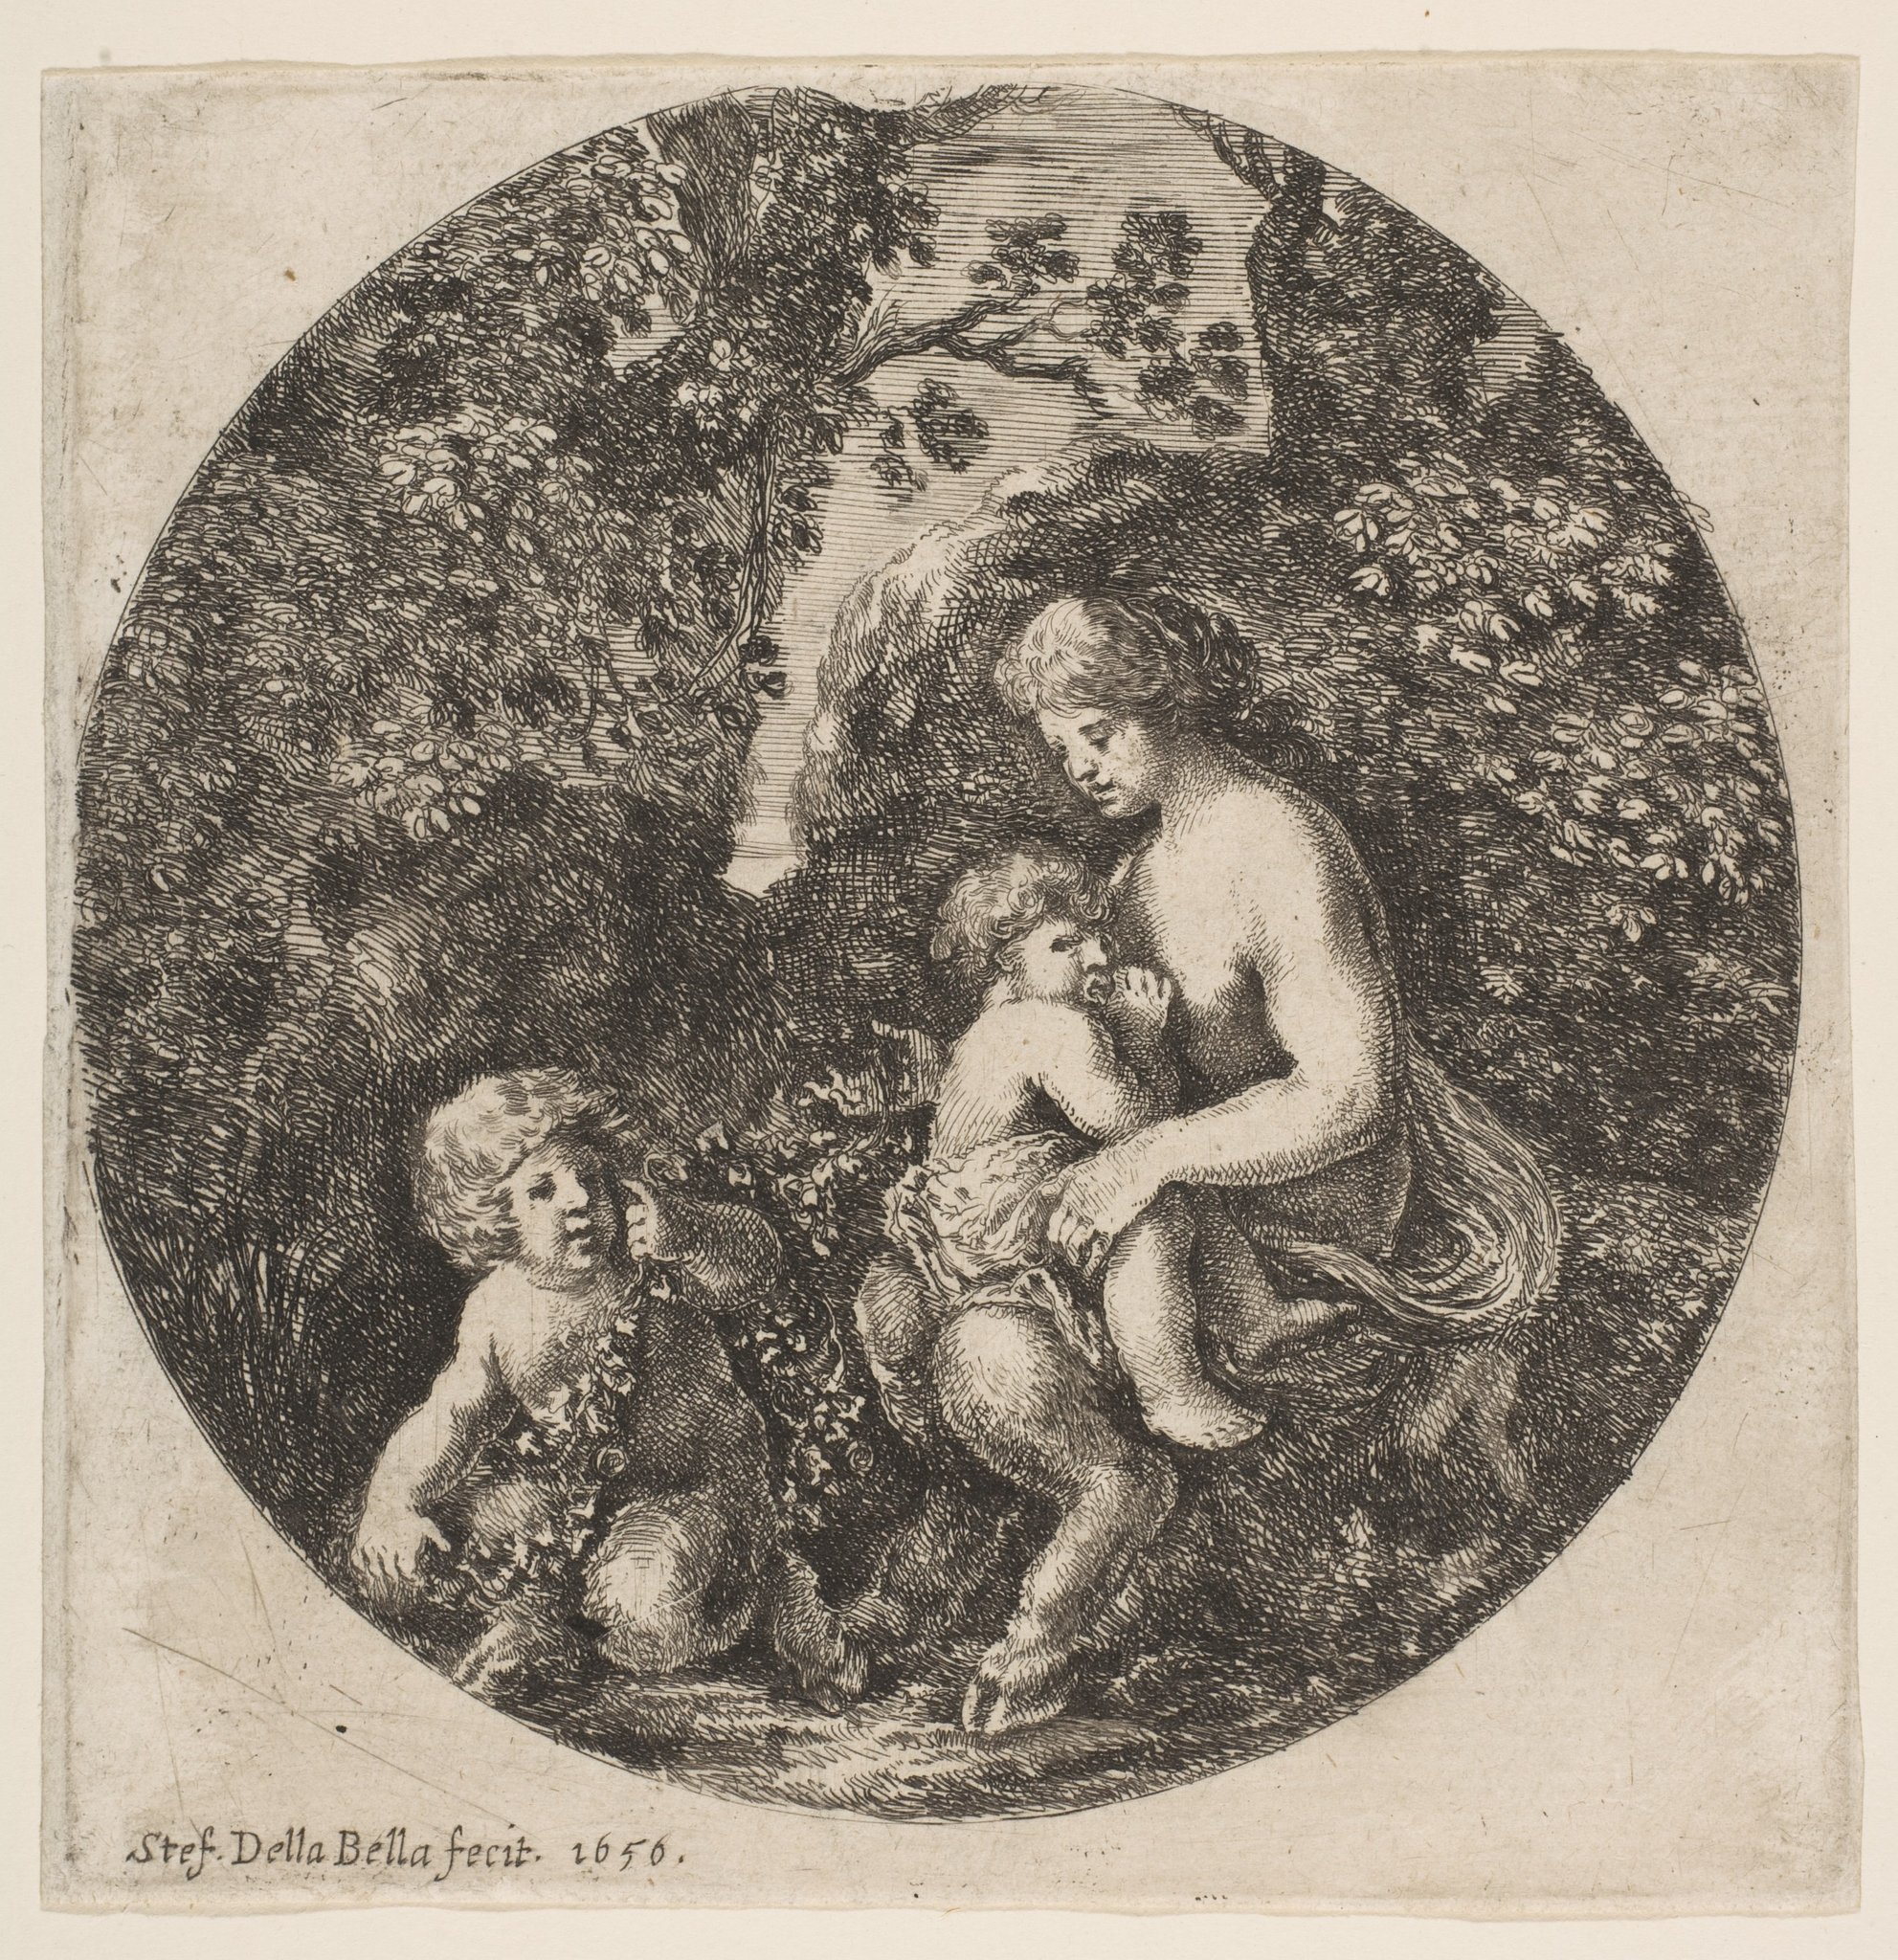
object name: print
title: Satyr family, from 'Landscapes and seaports' (Paysages et ports de mer, dans des ronds)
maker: stefano della bella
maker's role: artist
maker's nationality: italian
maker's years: 1610-1664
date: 1656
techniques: etching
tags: children,mothers,satyrs